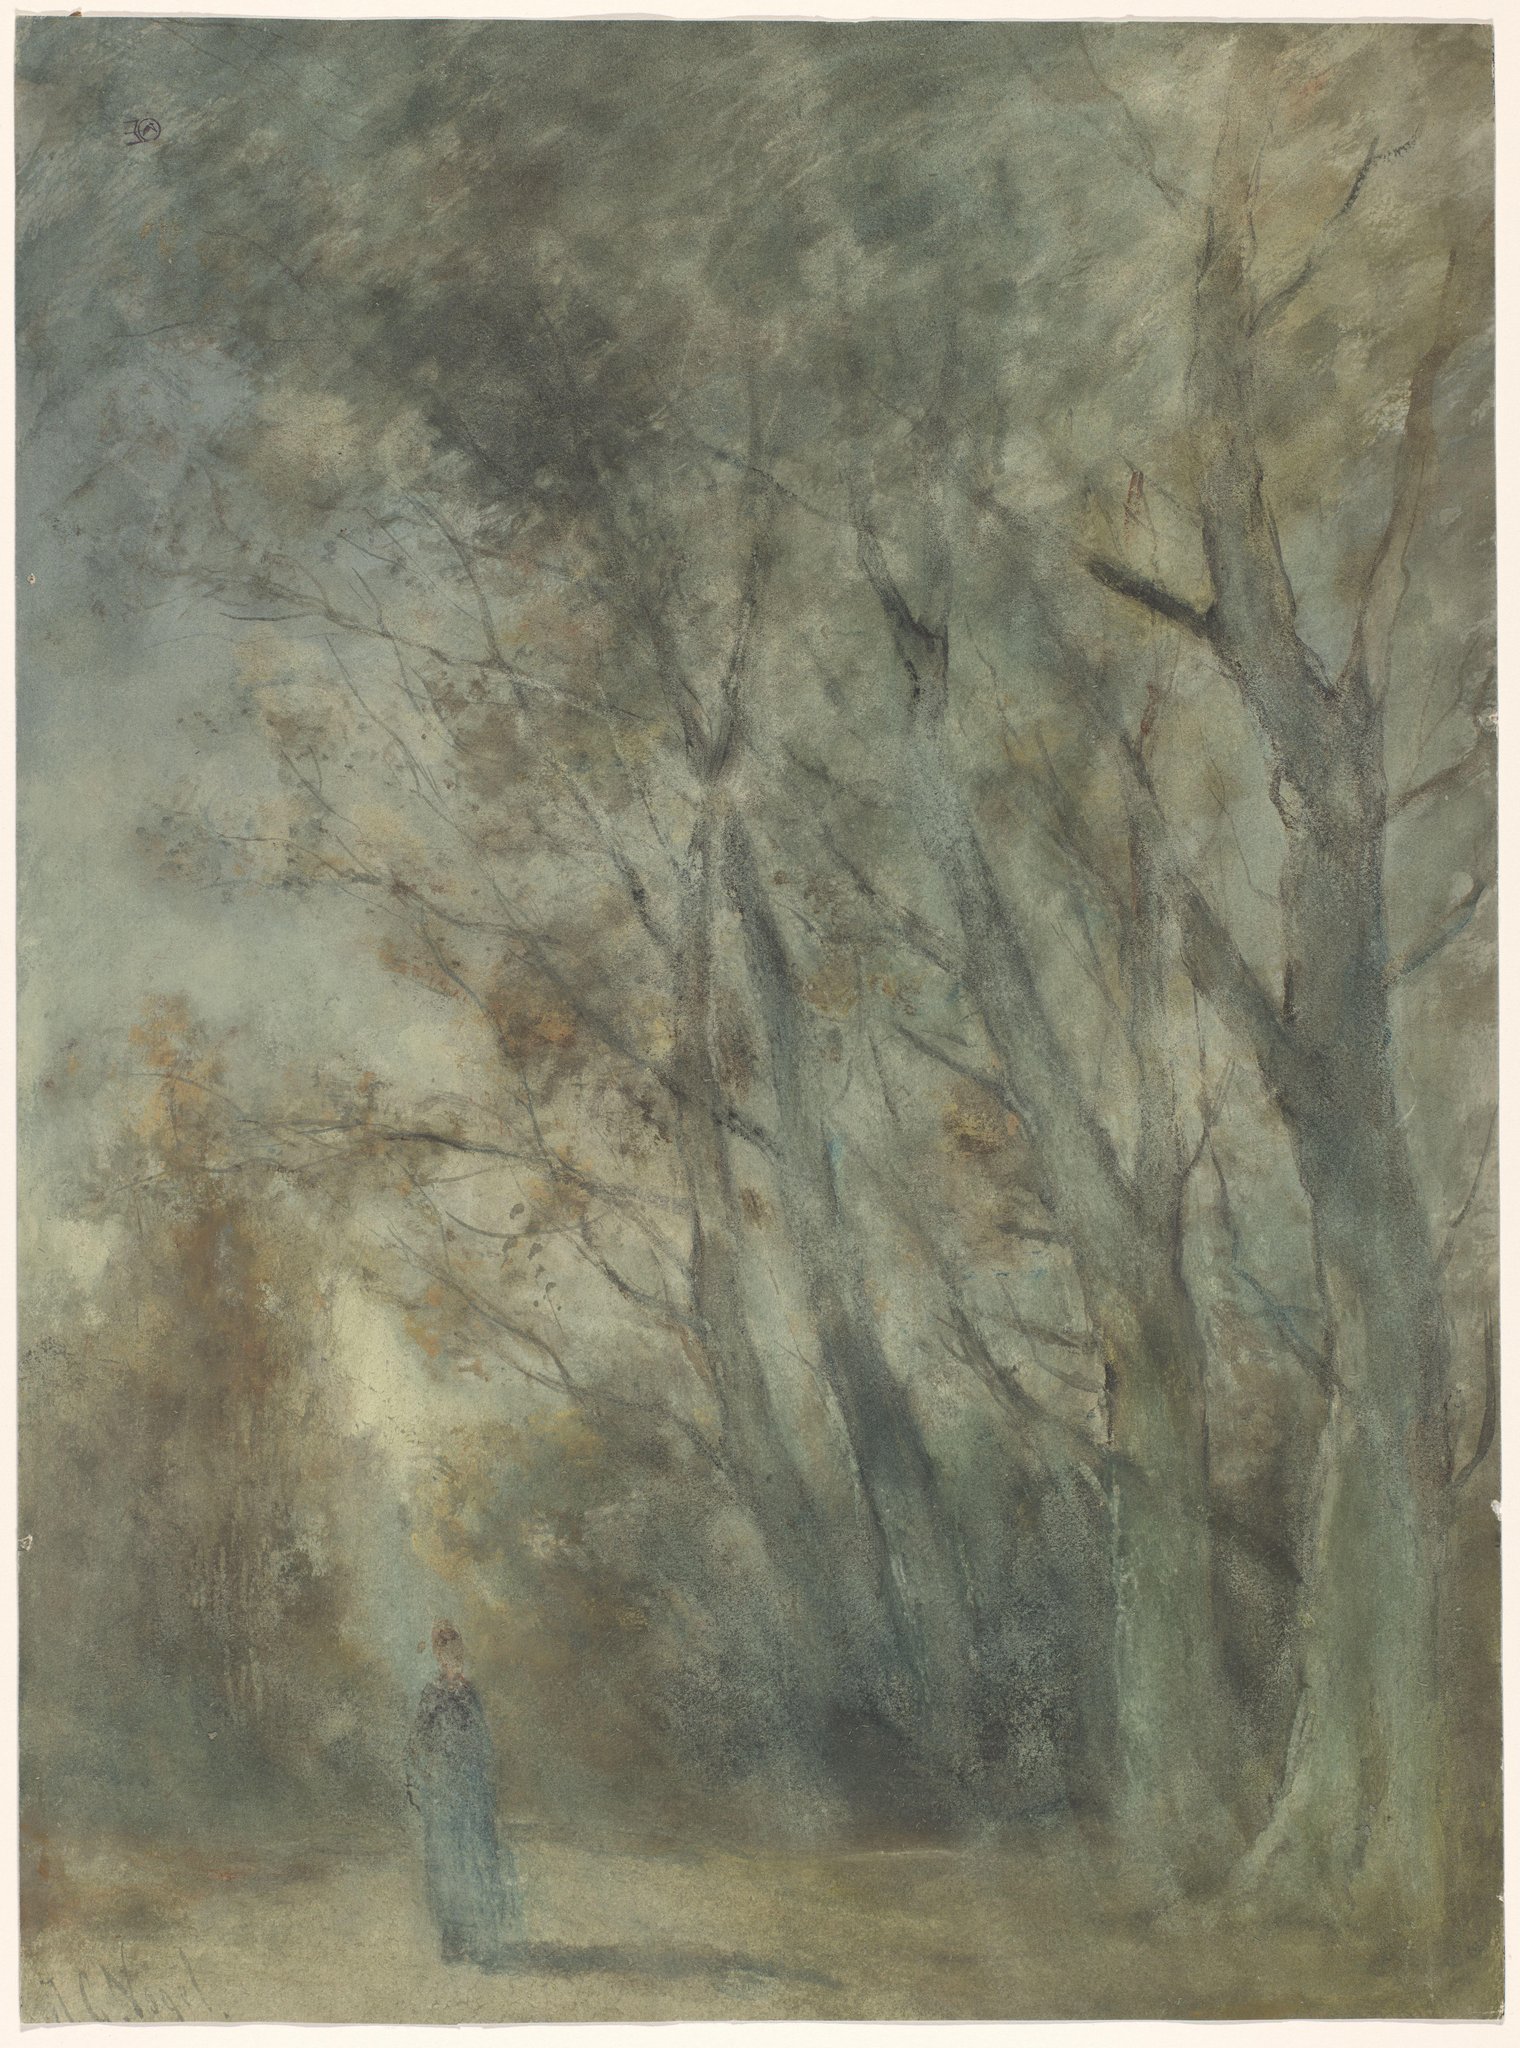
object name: drawing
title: Vrouw op een bospad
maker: johannes gijsbert vogel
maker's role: draughtsman, painter, print maker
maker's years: 1828-1915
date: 1838-1915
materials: chalk, paper, watercolor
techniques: brush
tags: forest path or lane (+ landscape with figures, staffage)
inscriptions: collector's mark: Lugt 1181b